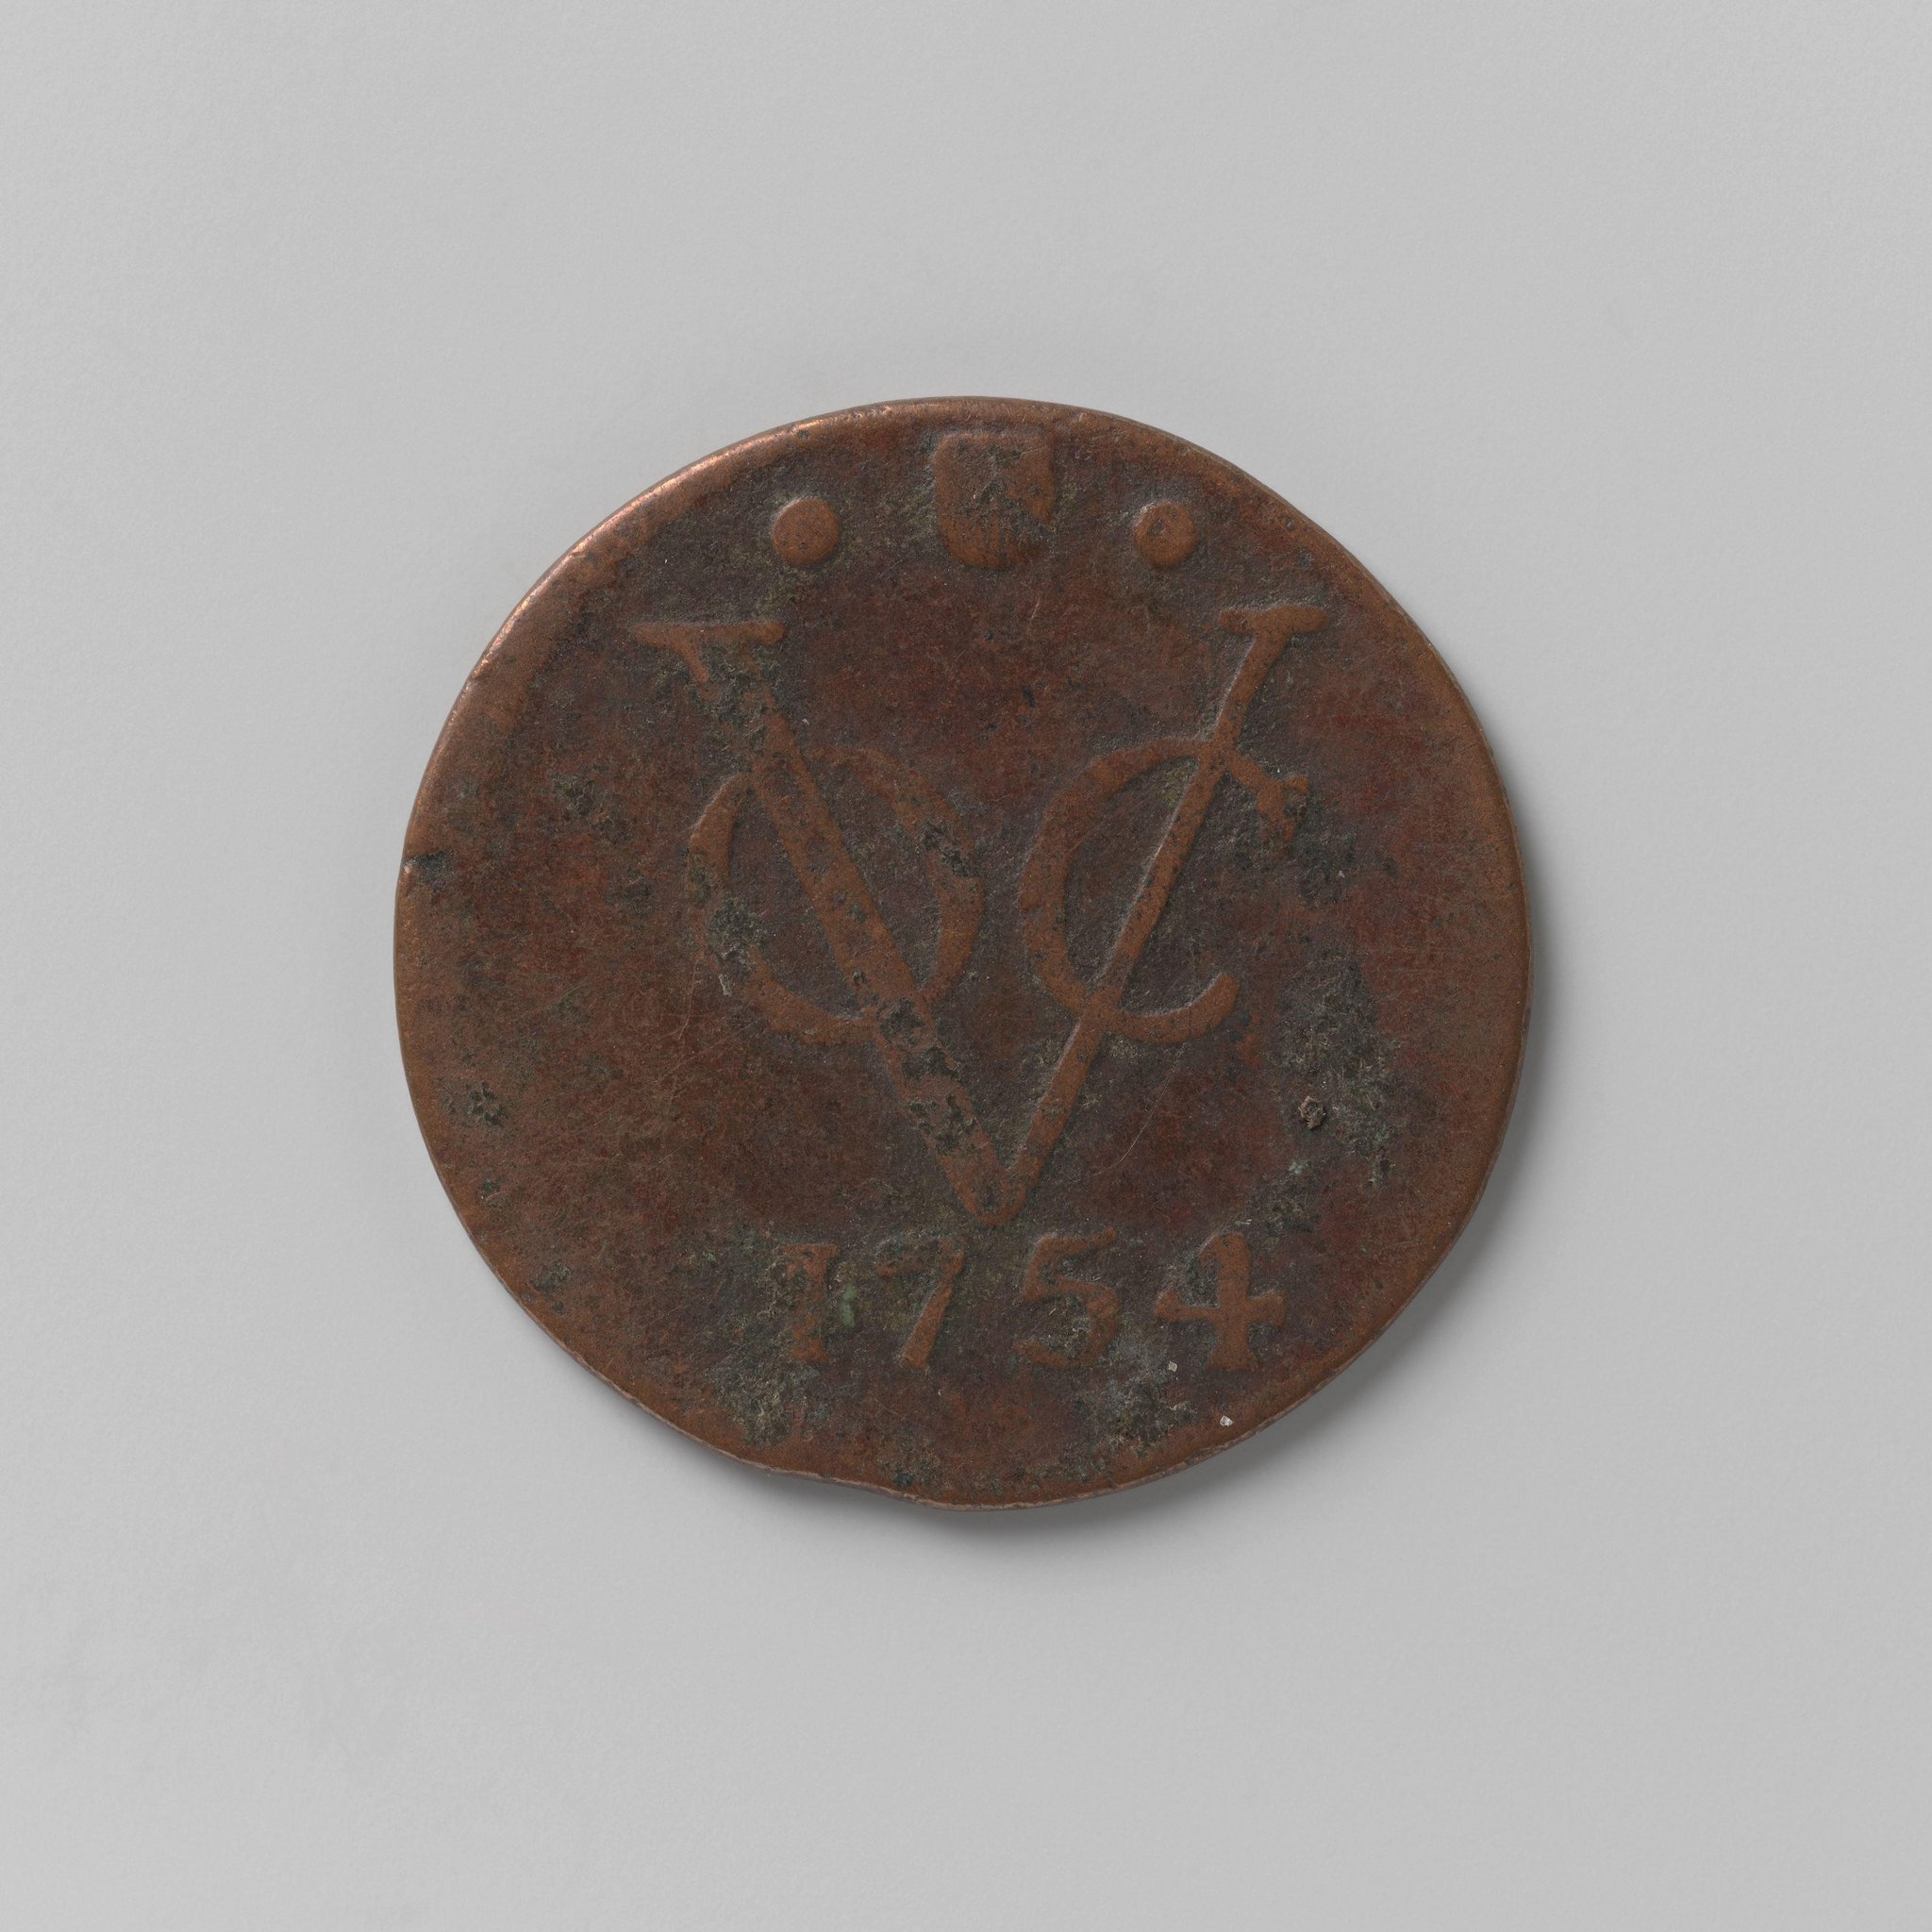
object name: coin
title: VOC, ½ duit stad Utrecht,1754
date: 1754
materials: copper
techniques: striking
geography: utrecht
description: Koperen munt. Voorzijde: gekroond ingebogen wapenschild van de stad Utrecht. Keerzijde: monogram van de VOC, waarboven muntteken en waaronder jaartal. Gladde rand.